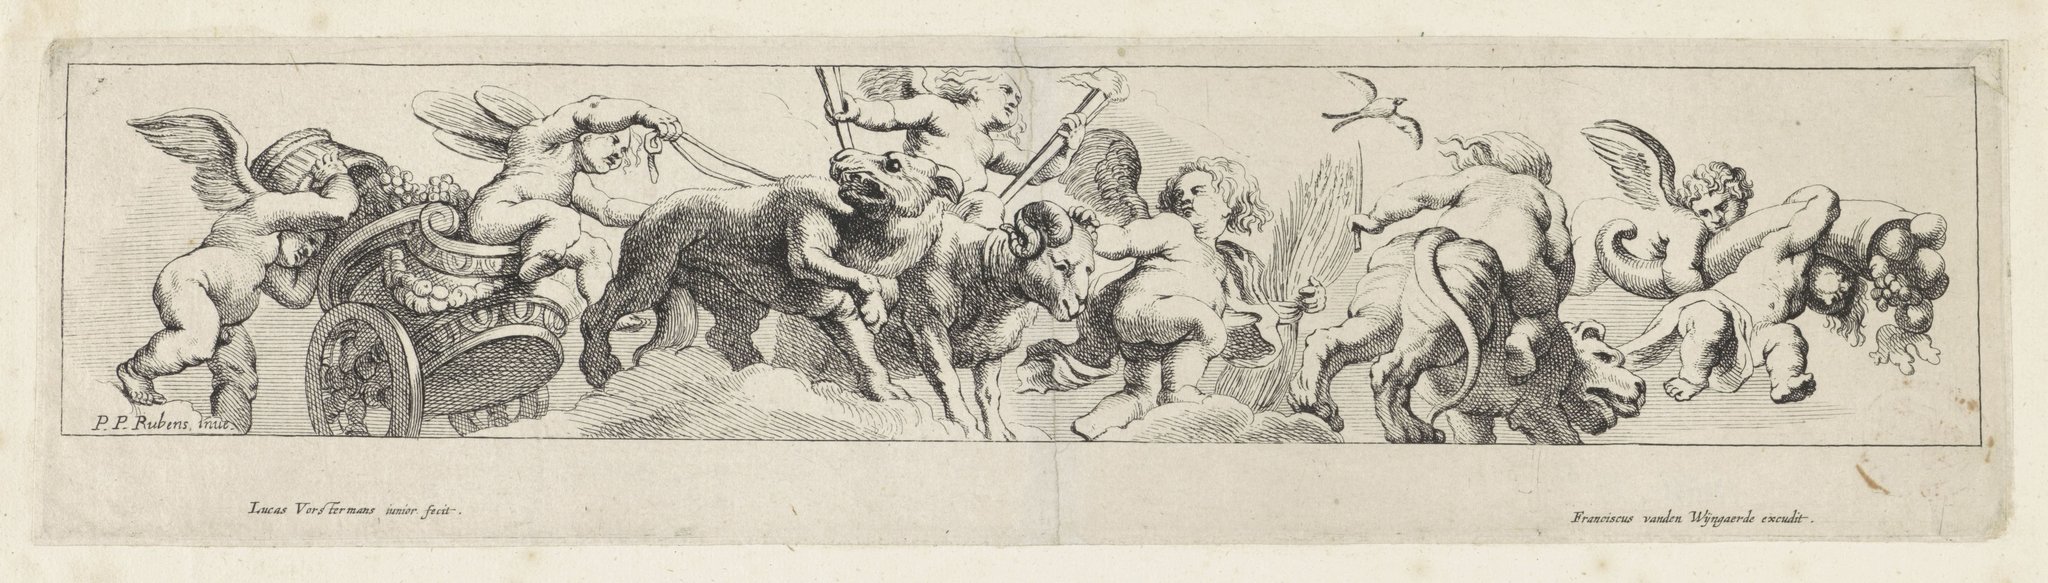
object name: print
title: Fries met spelende putti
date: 1651-1679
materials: paper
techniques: engraving, etching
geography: antwerp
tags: cupids: 'amores', 'amoretti', 'putti'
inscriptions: collector's mark: Lugt 240